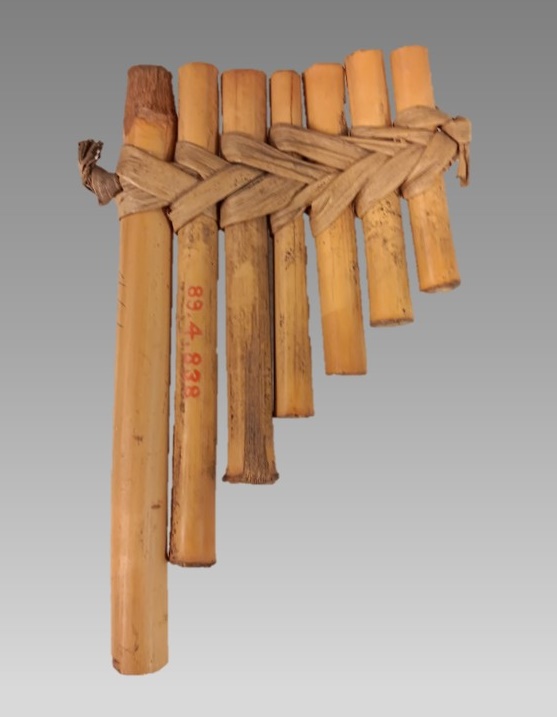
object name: pachava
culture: melanesian, pentecost island or vanuatu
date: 1867-1900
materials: bamboo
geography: vanuatu